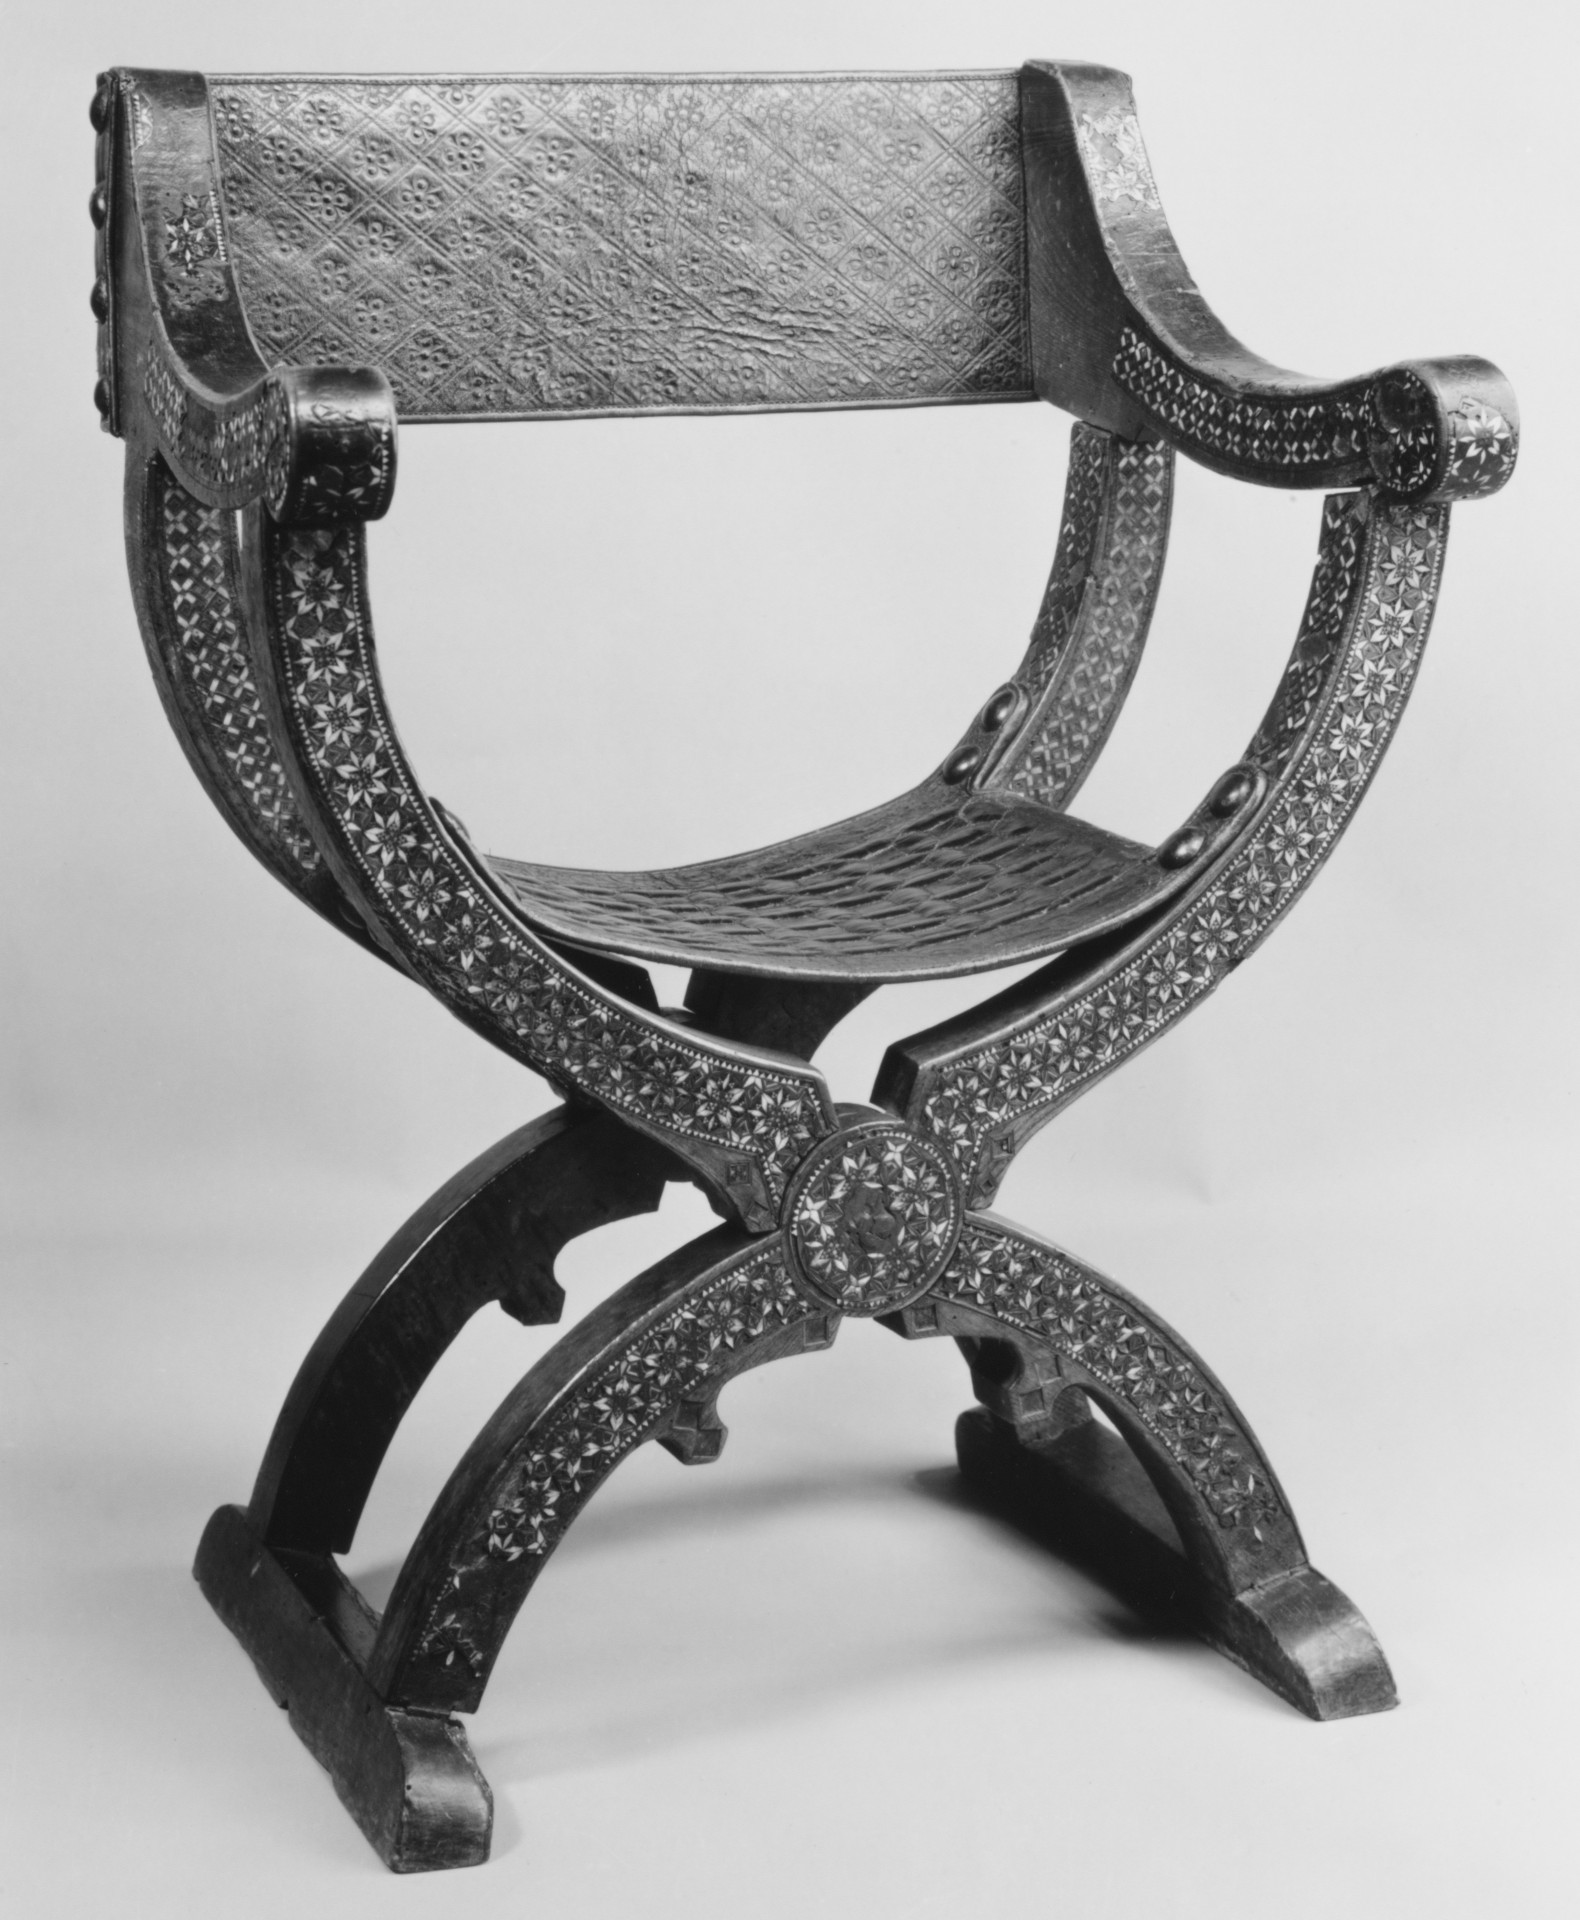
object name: folding chair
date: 1500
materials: bone, ivory, mother of pearl, velvet, wood